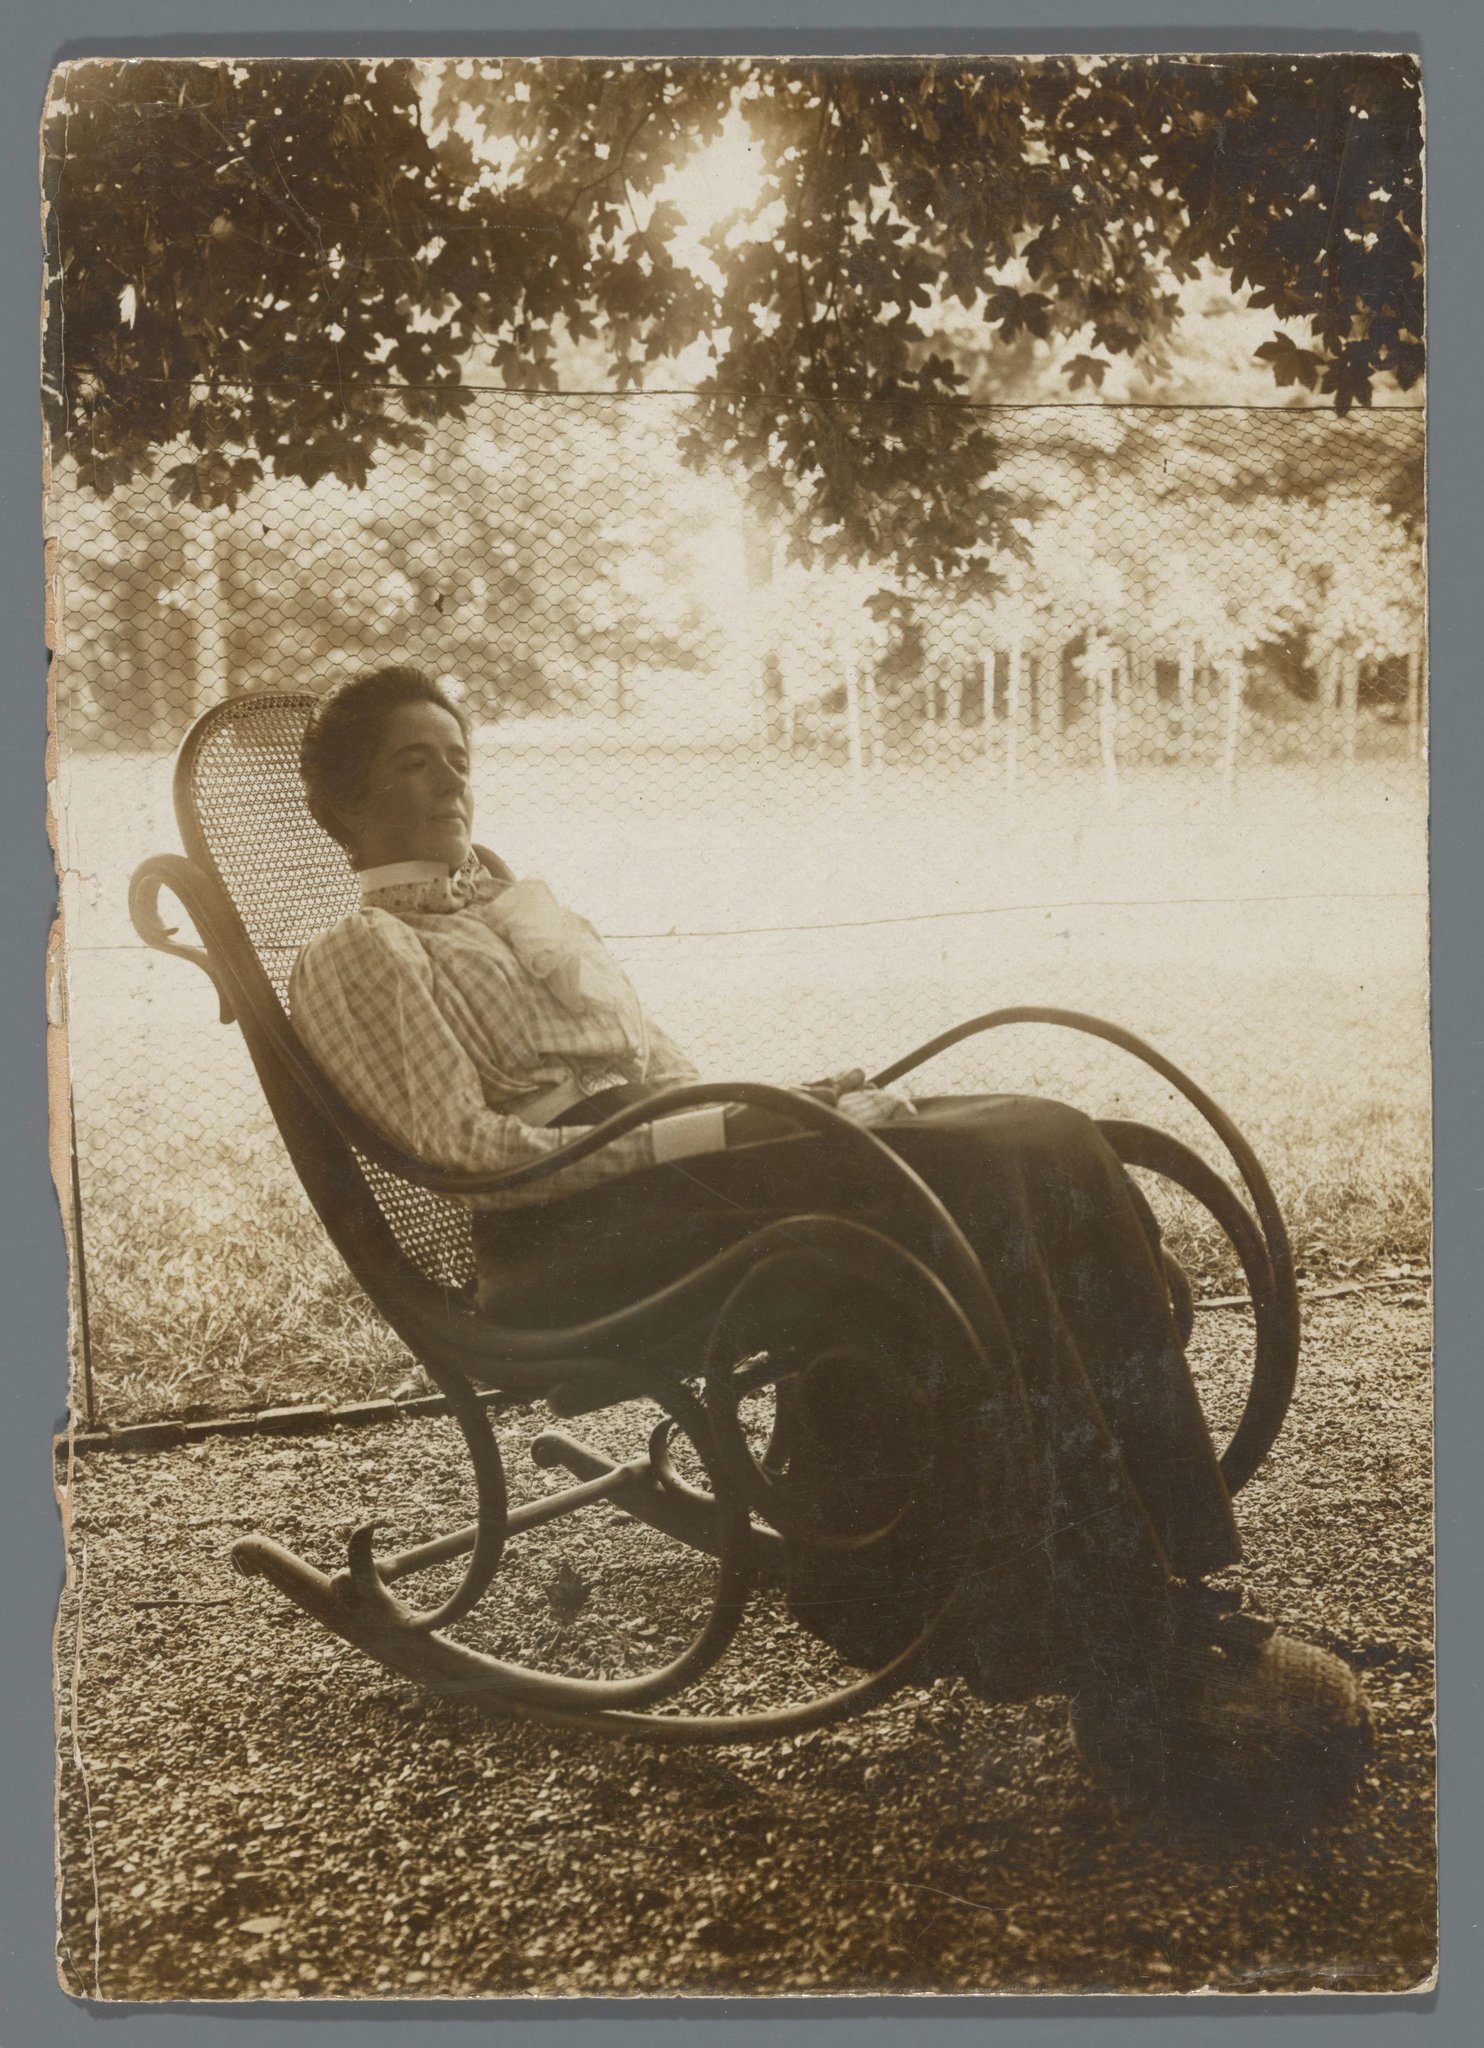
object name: photograph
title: Portret van Cornelia Hendrika Jonker in een schommelstoel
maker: cornelia hendrika jonker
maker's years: 1874-1924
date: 1880-1940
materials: photographic support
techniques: collodion silver print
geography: amsterdam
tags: cornelia hendrika jonker, rocking-chair, historical persons, amsterdam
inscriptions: annotation: ‘C.H. Jonker/ Cor/ W. Parkweg 204/ Amsterdam’